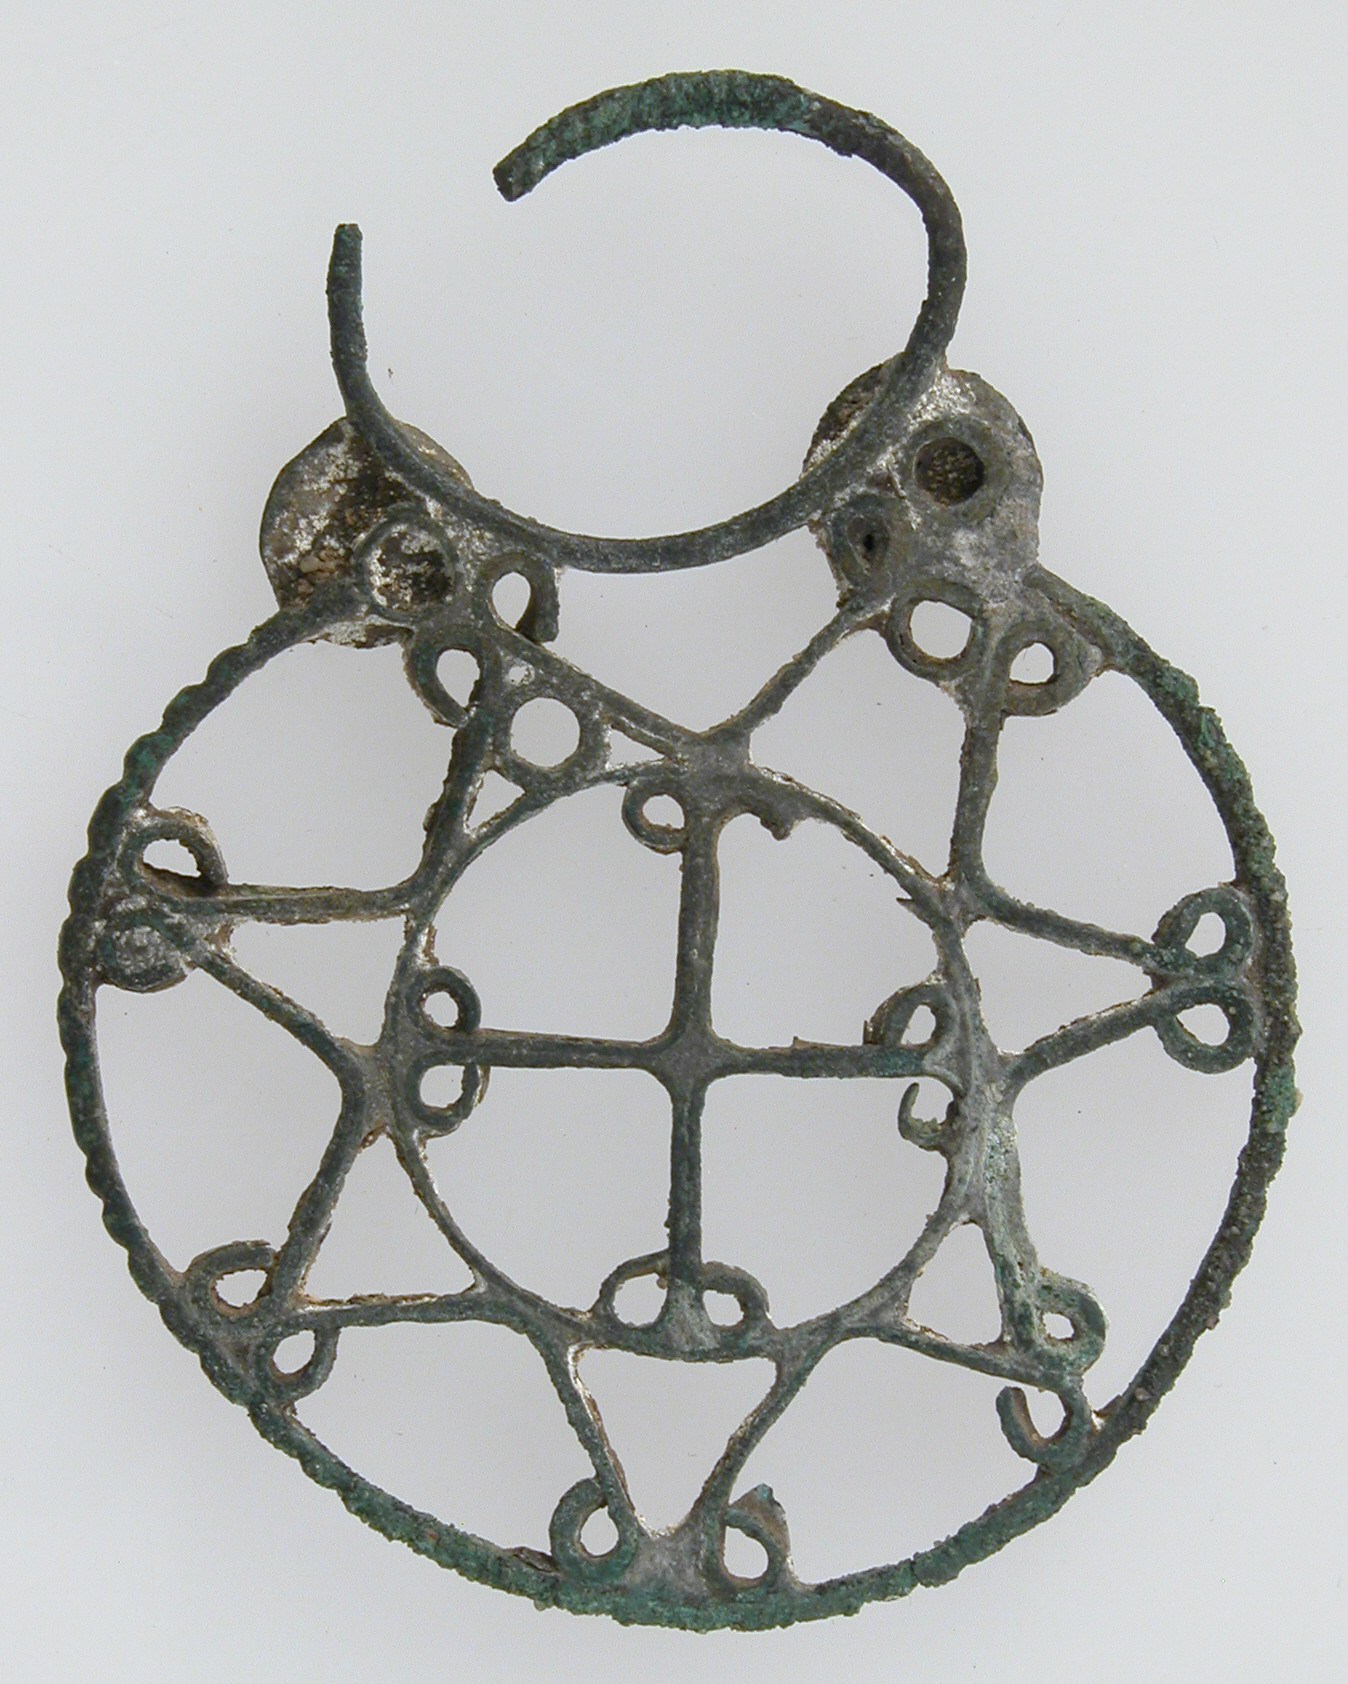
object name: plaque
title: Plaque, Openwork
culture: byzantine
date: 401-600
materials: bronze